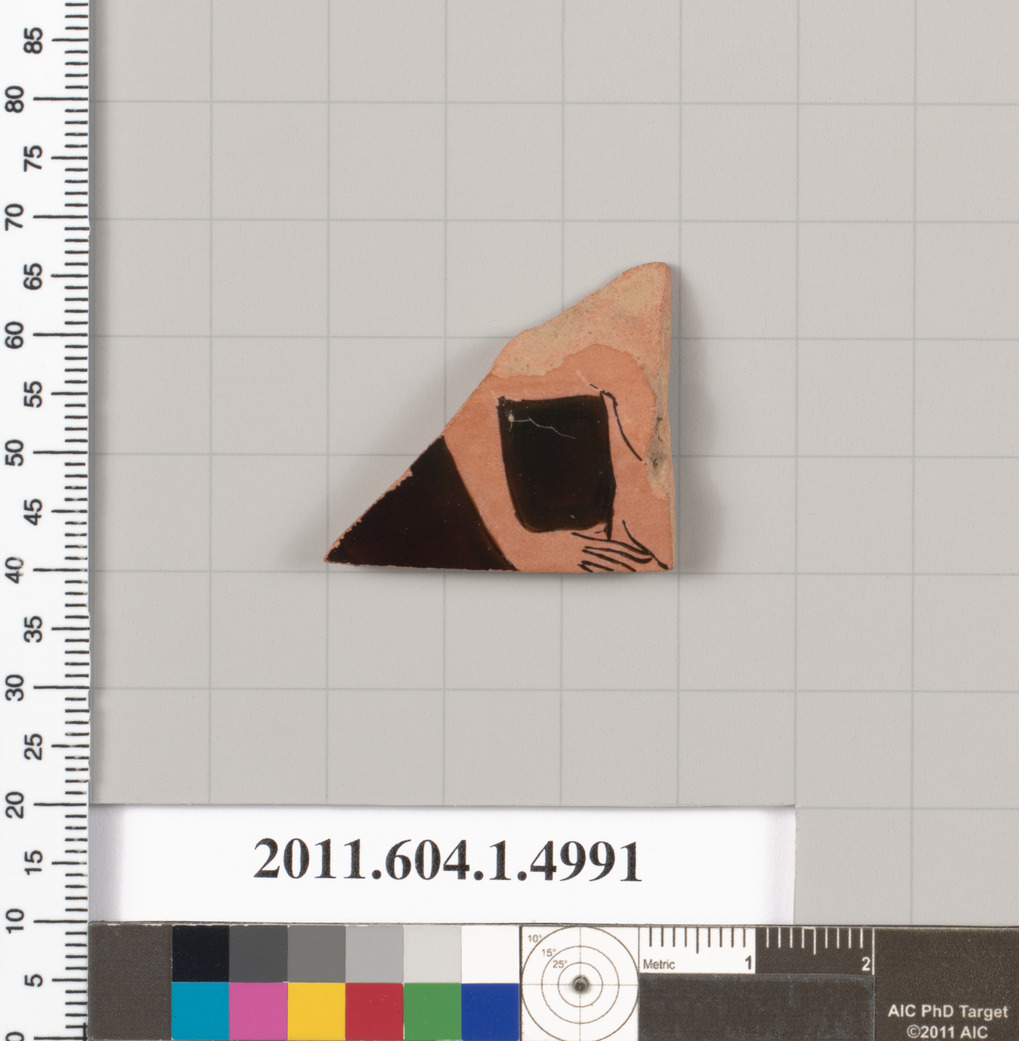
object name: kylix fragment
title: Terracotta fragment of a kylix (drinking cup)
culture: greek, attic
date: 490-470 BCE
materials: terracotta